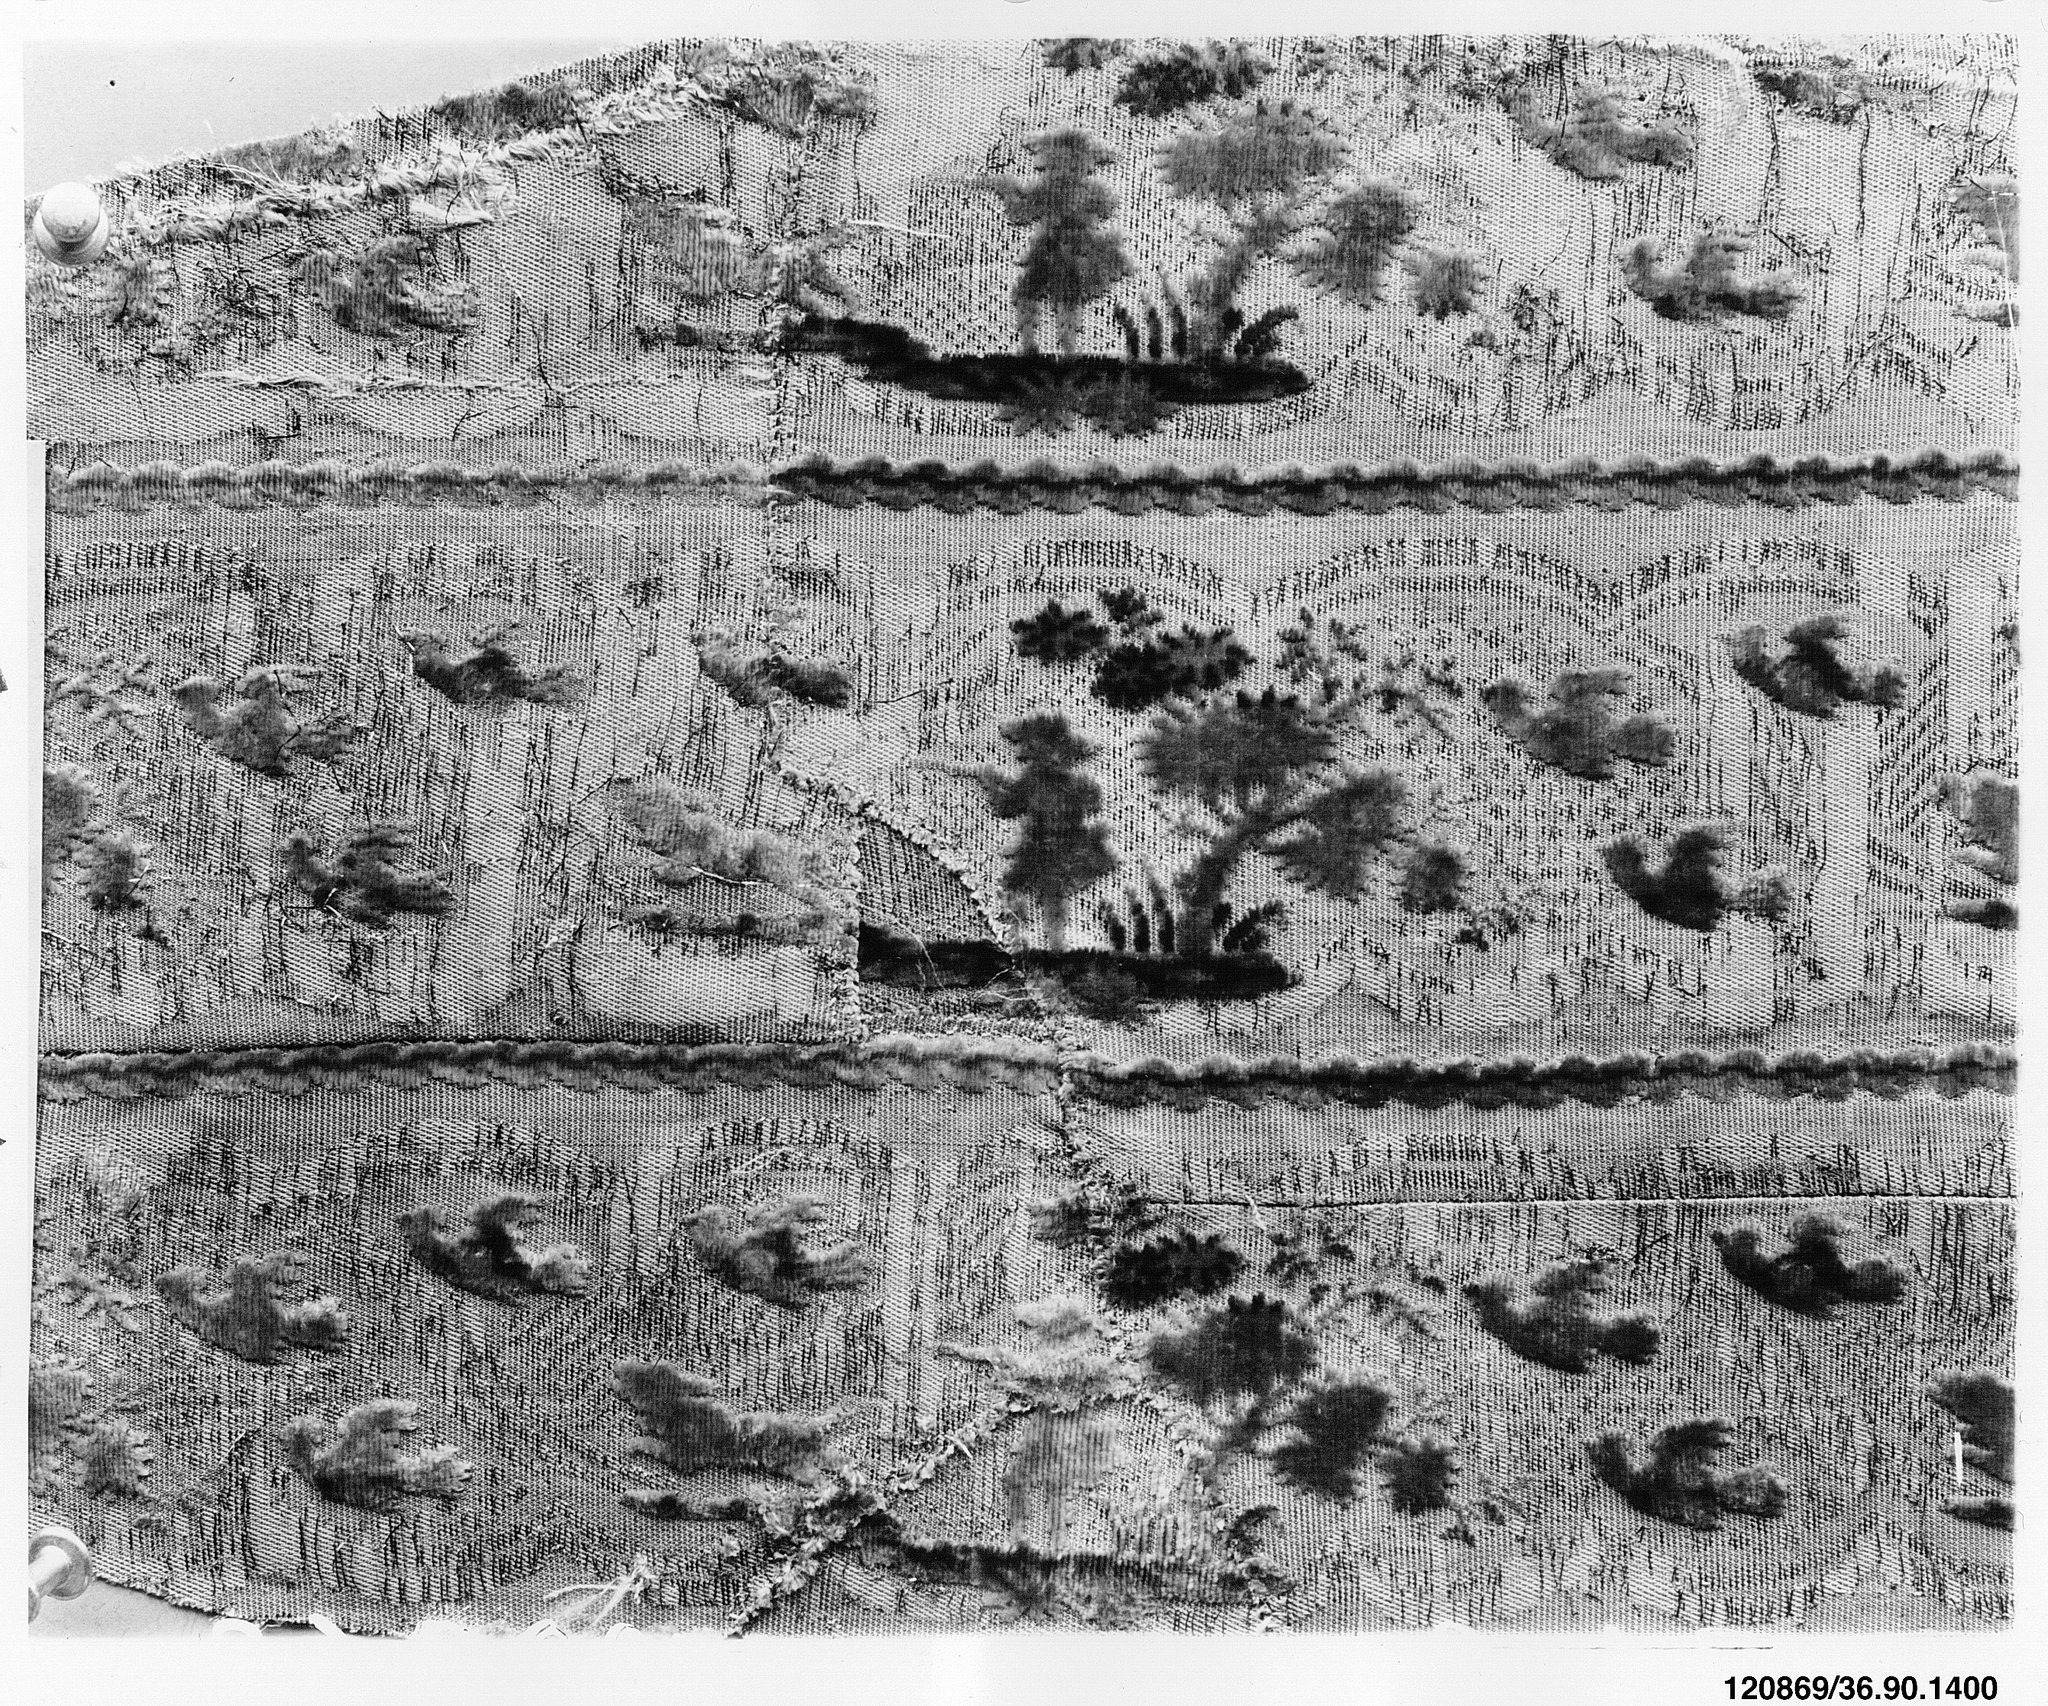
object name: piece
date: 1701-1800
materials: silk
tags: human figures,birds,trees